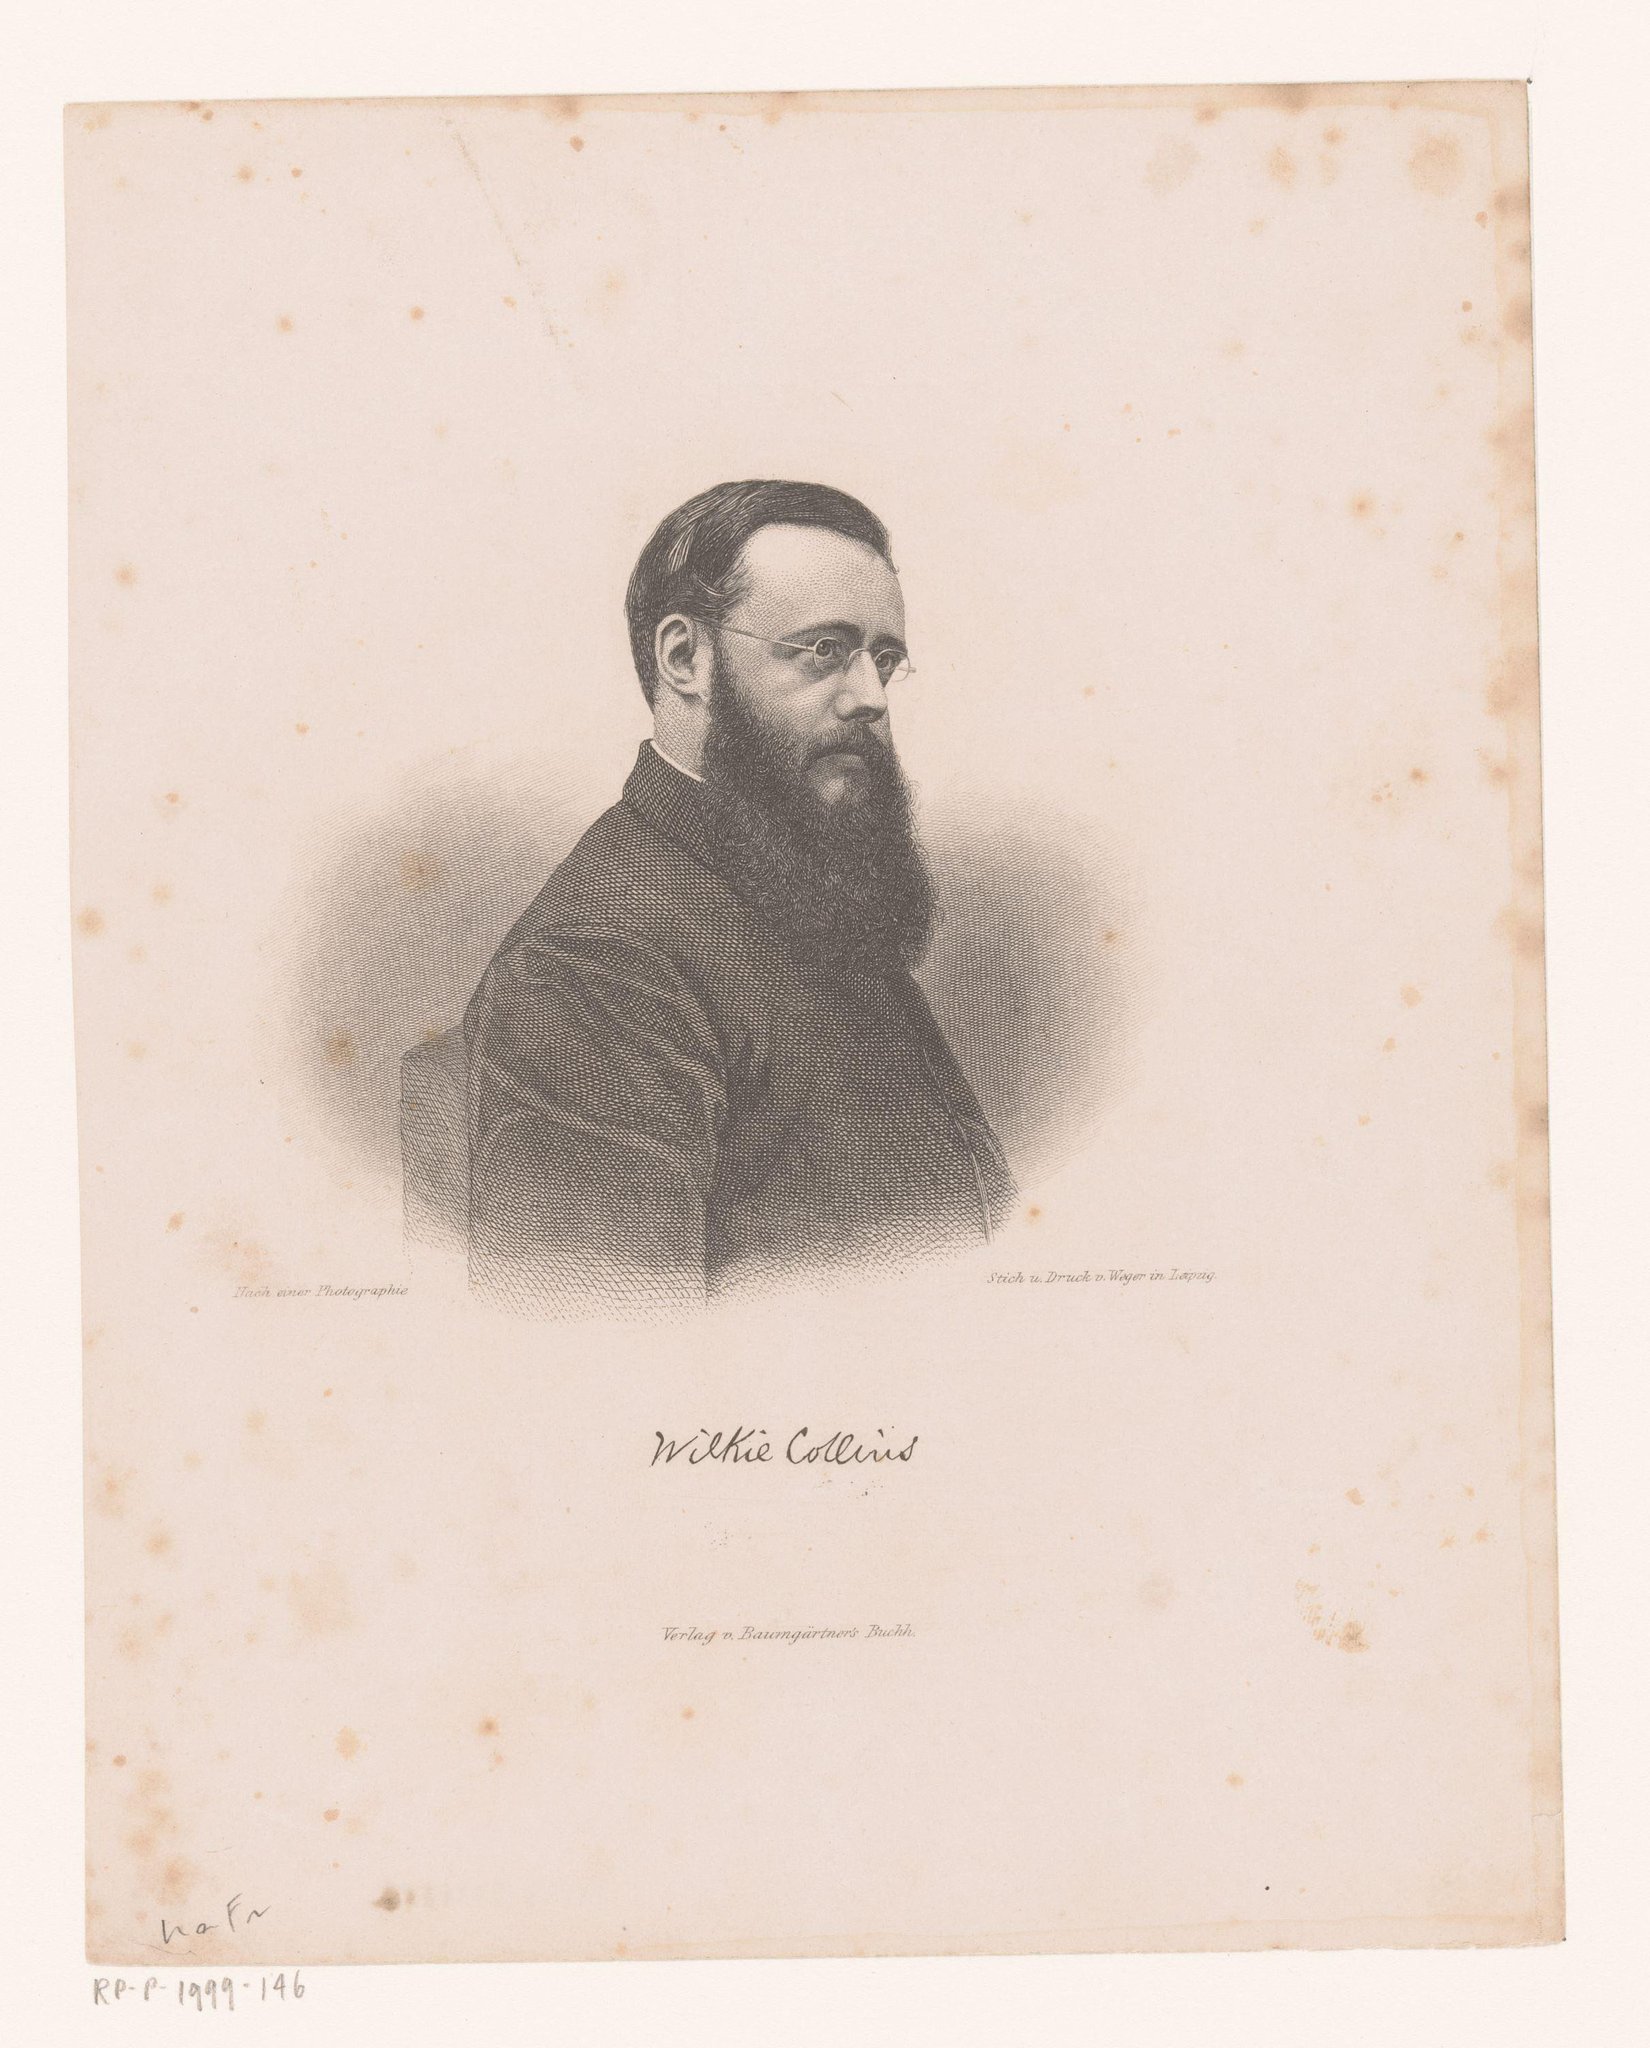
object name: print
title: Portret van Wilkie Collins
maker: august weger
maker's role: print maker, printer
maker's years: 1823-1892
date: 1849-1892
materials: paper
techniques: engraving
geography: leipzig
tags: london, historical persons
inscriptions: collector's mark: Lugt 2228